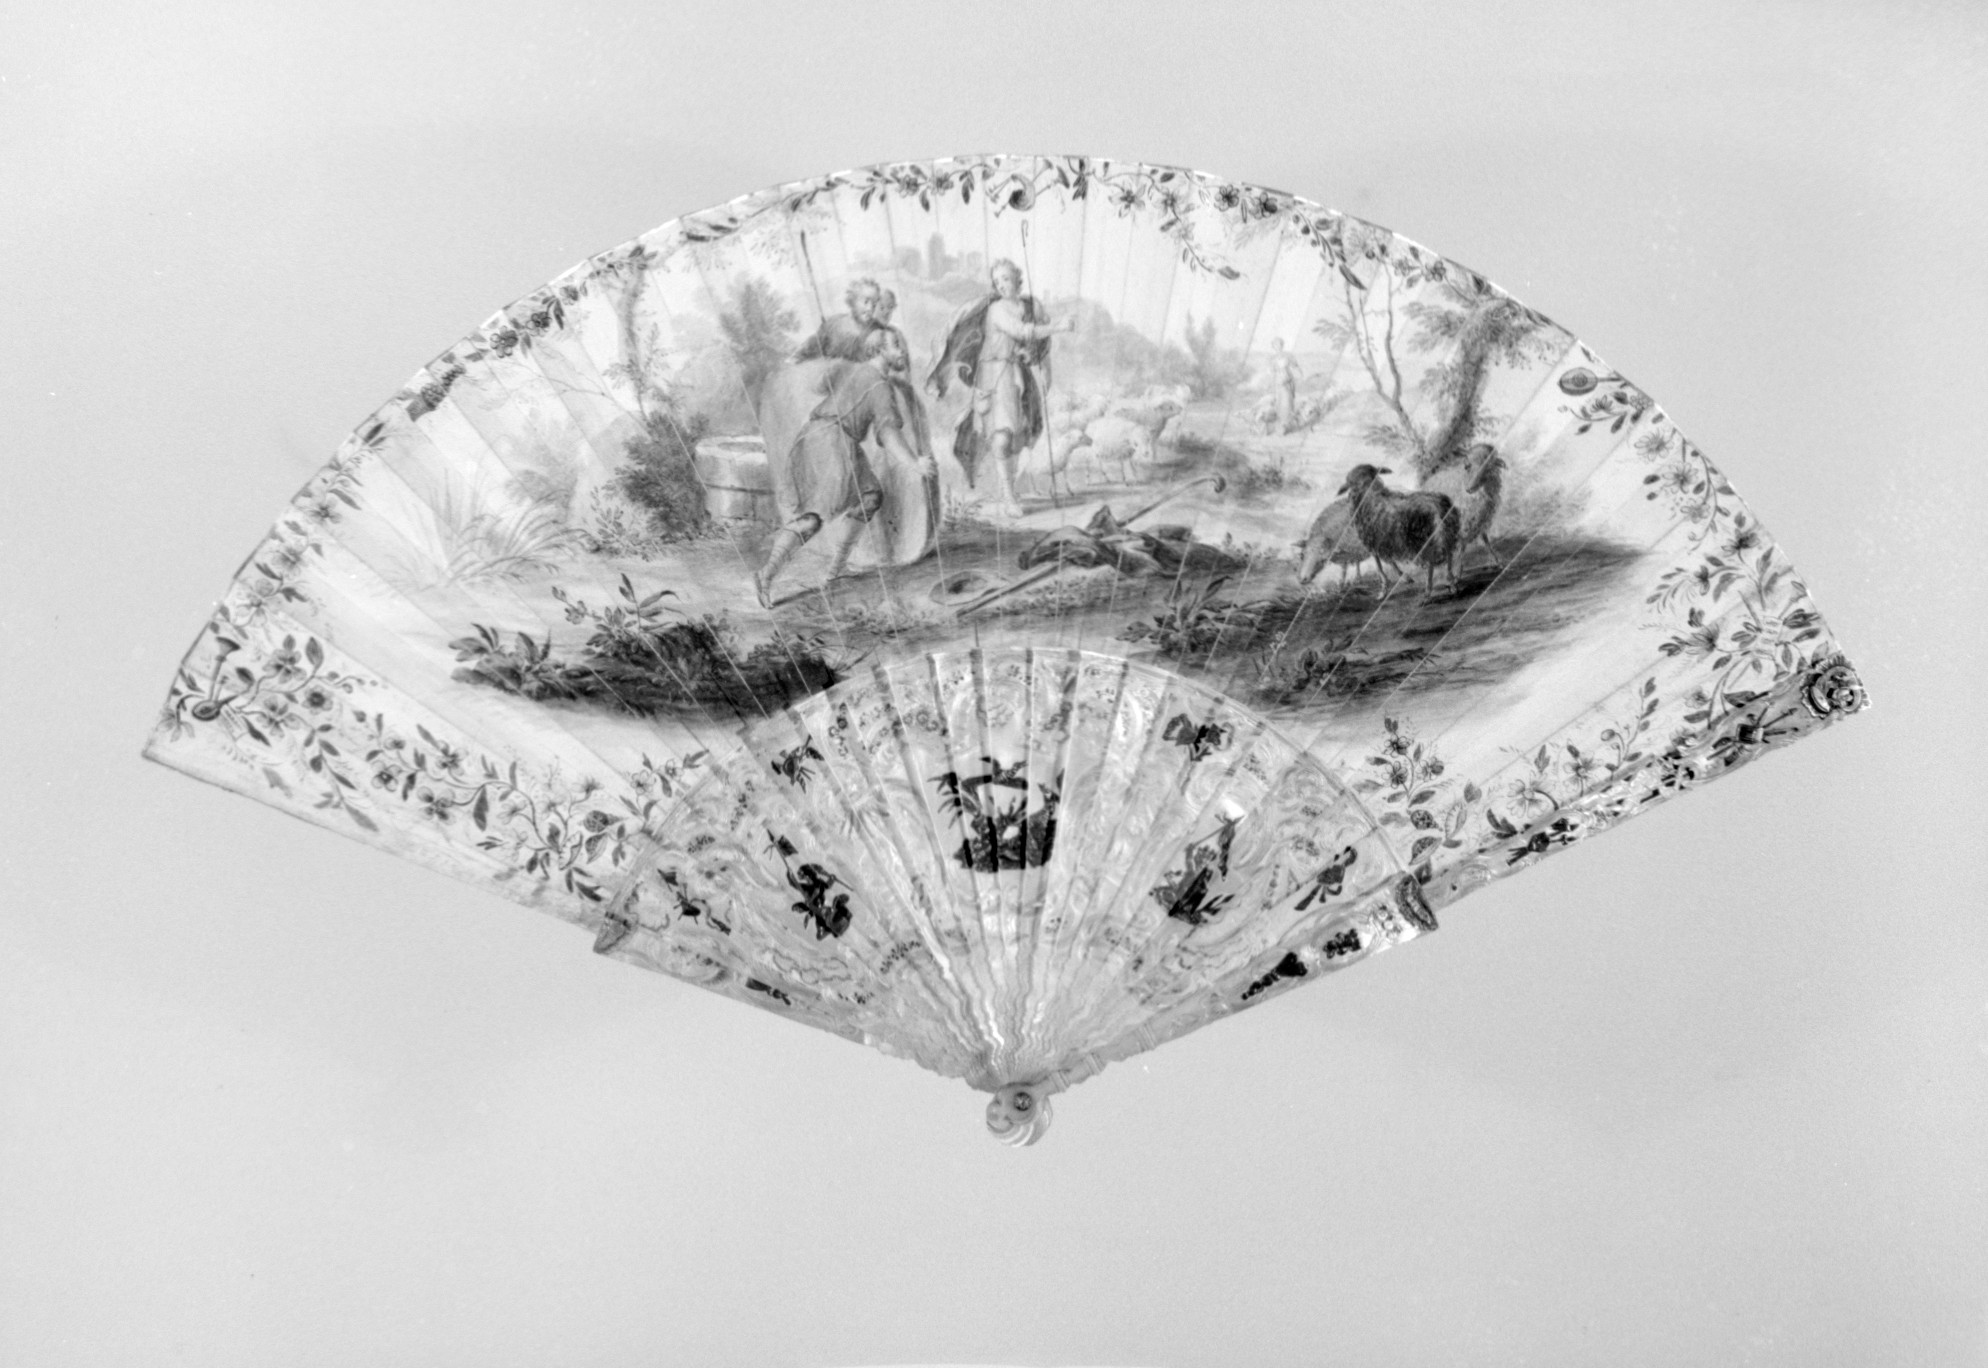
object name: fan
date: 1701-1800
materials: mother of pearl, paper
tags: men,sheep,shepherds